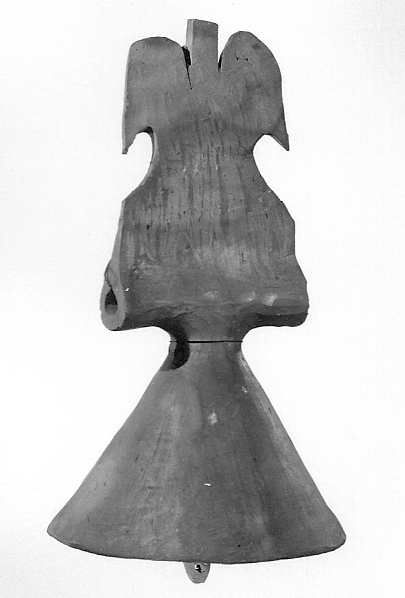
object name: pottery bell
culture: mexican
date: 1801-1900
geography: mexico